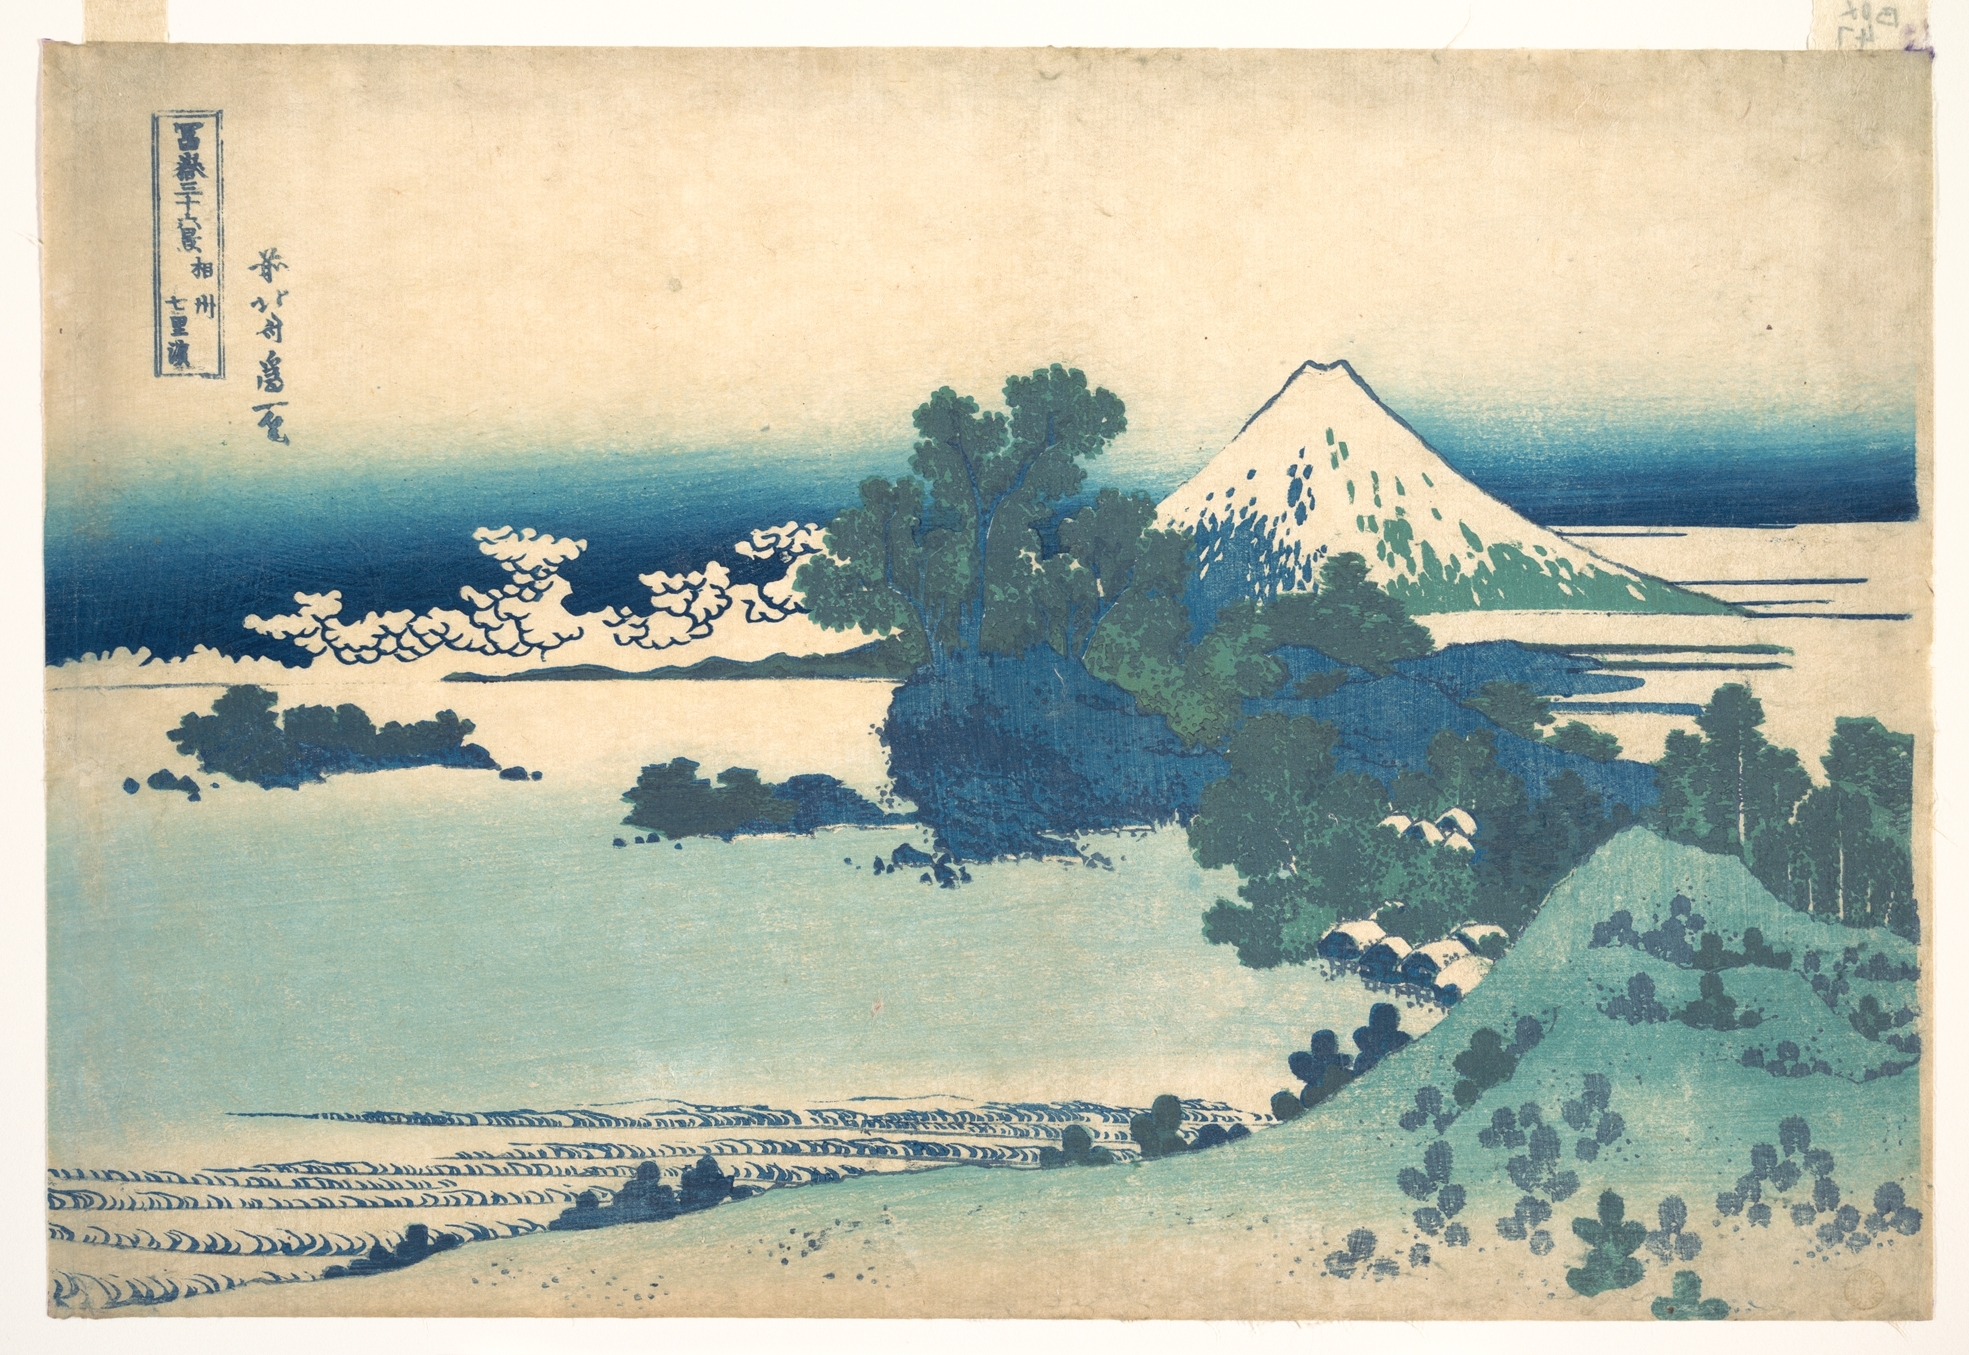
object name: woodblock print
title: Shichirigahama in Sagami Province (Sōshū Shichirigahama), from the series Thirty-six Views of Mount Fuji (Fugaku sanjūrokkei)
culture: japanese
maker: katsushika hokusai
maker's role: artist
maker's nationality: japanese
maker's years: 1760-1849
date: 1830-1832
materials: ink, paper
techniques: woodblock print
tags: mountains,landscapes